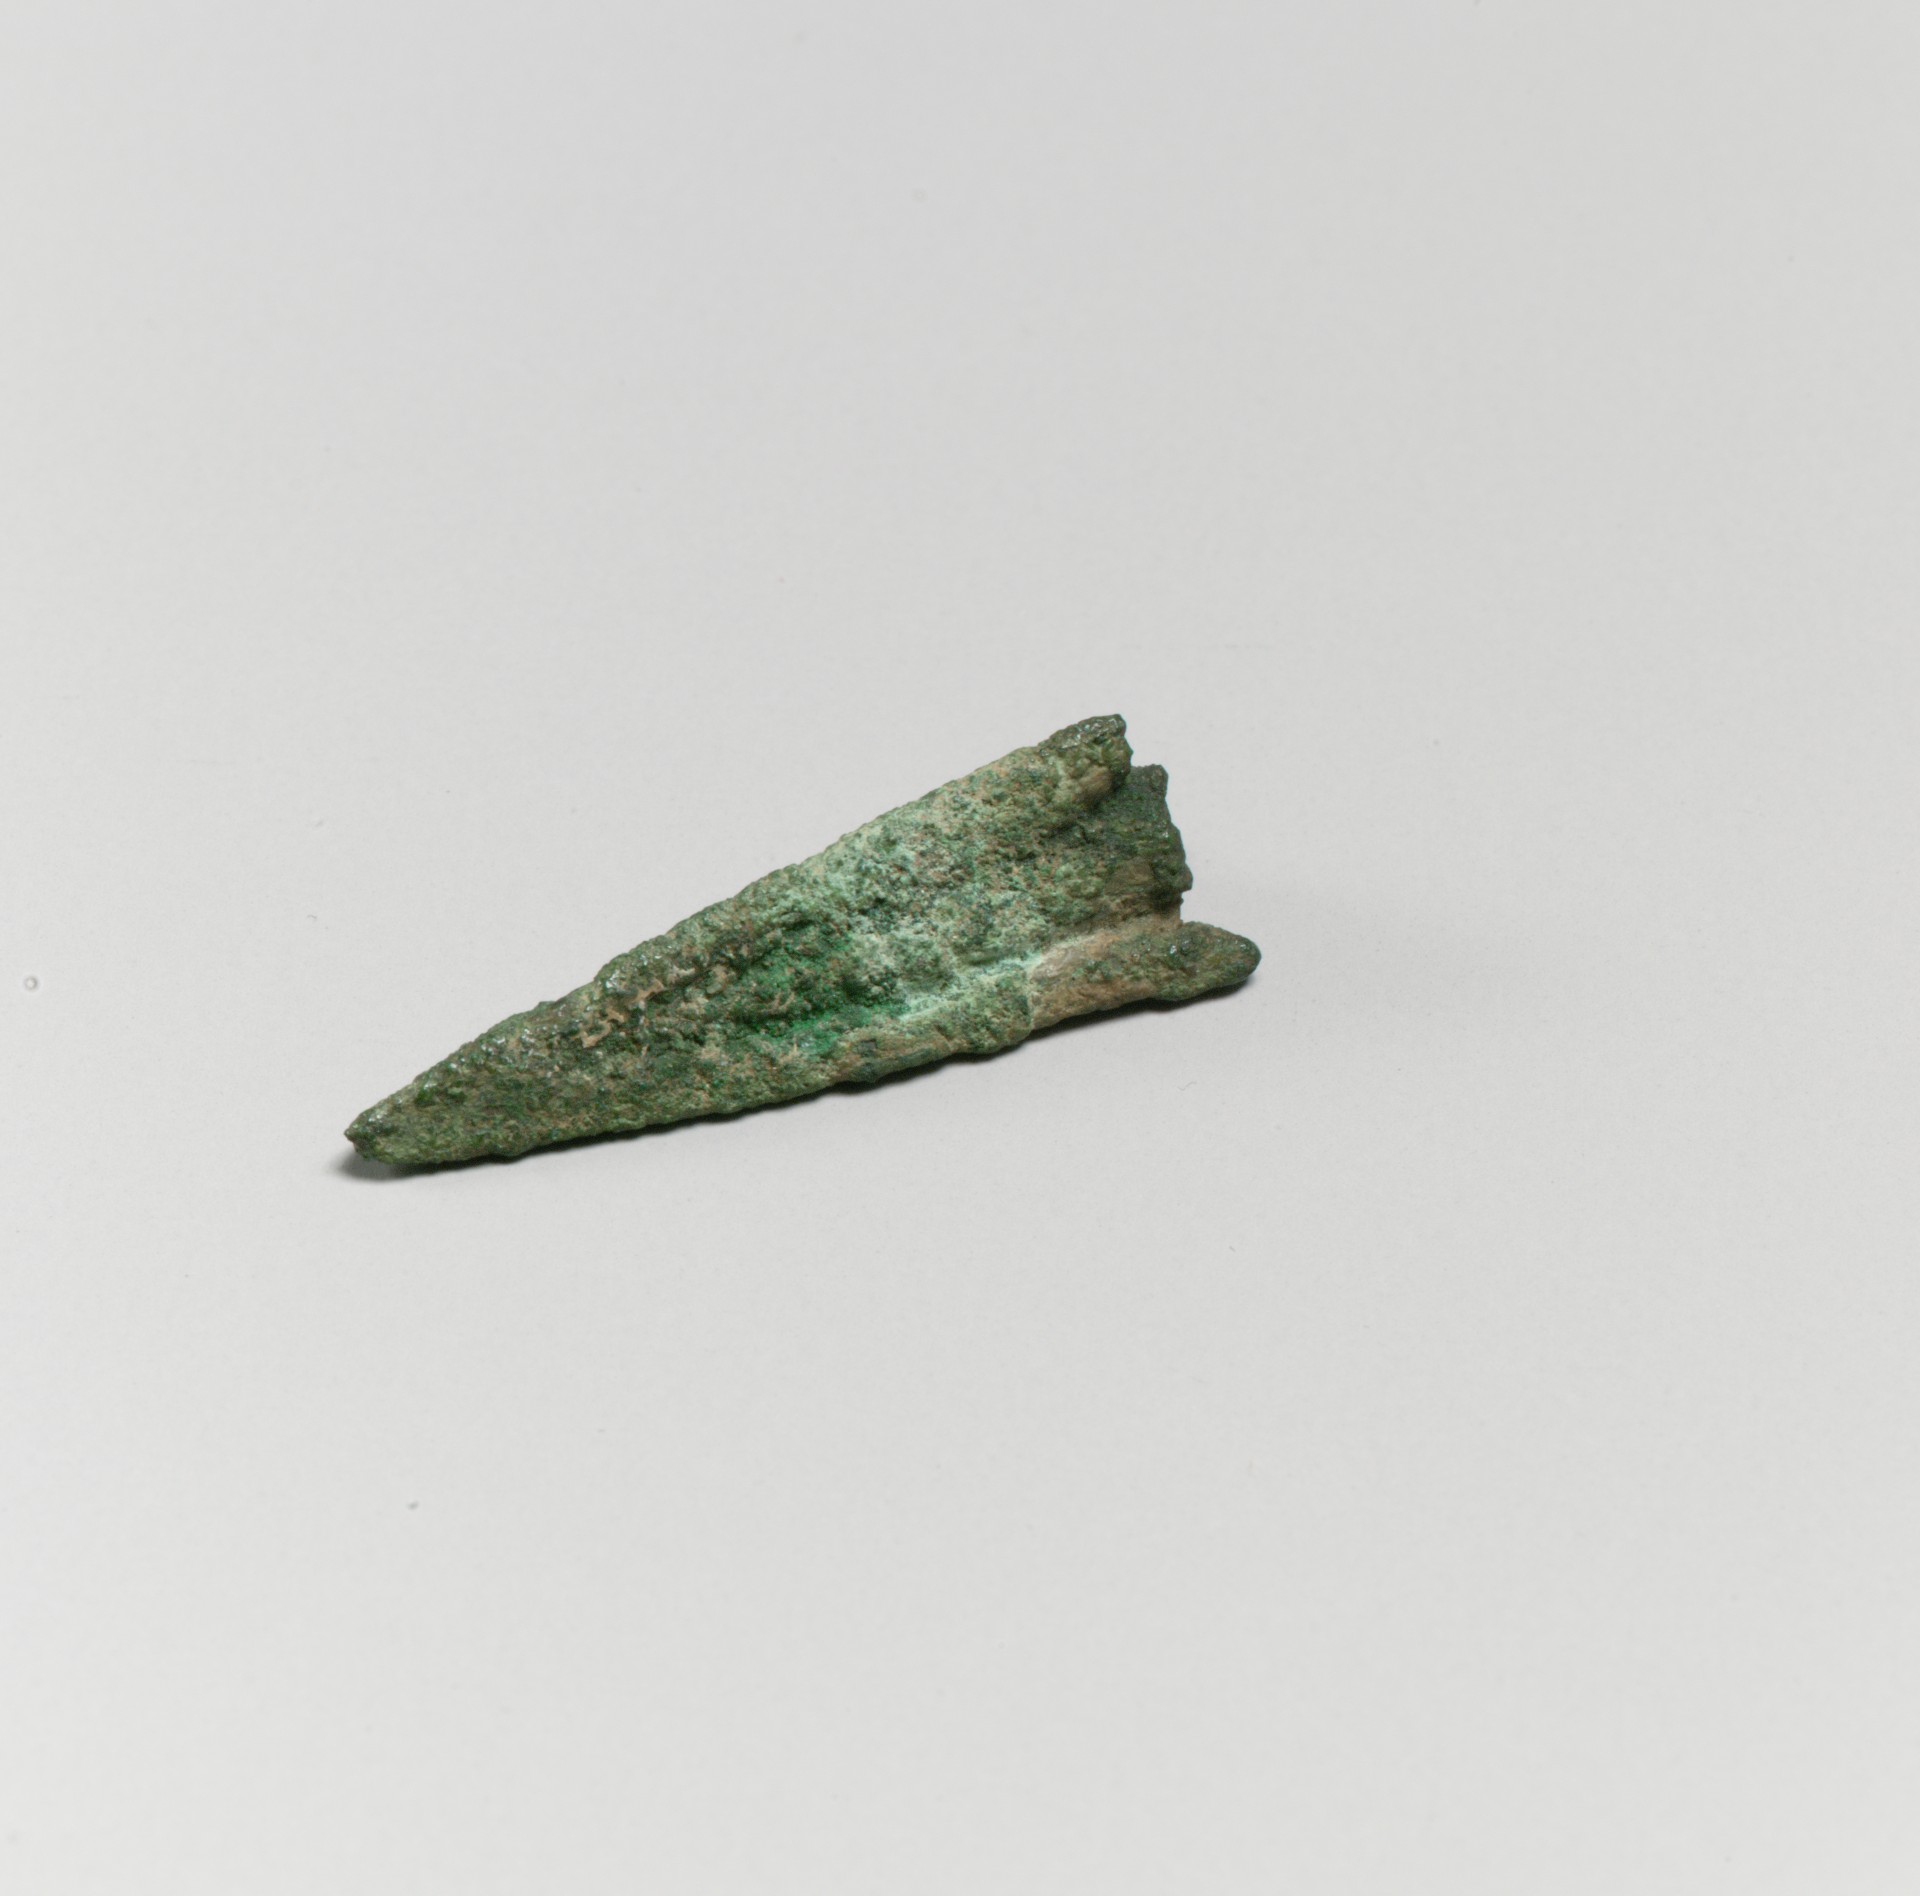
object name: arrowhead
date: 7000 BCE-330 CE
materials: bronze